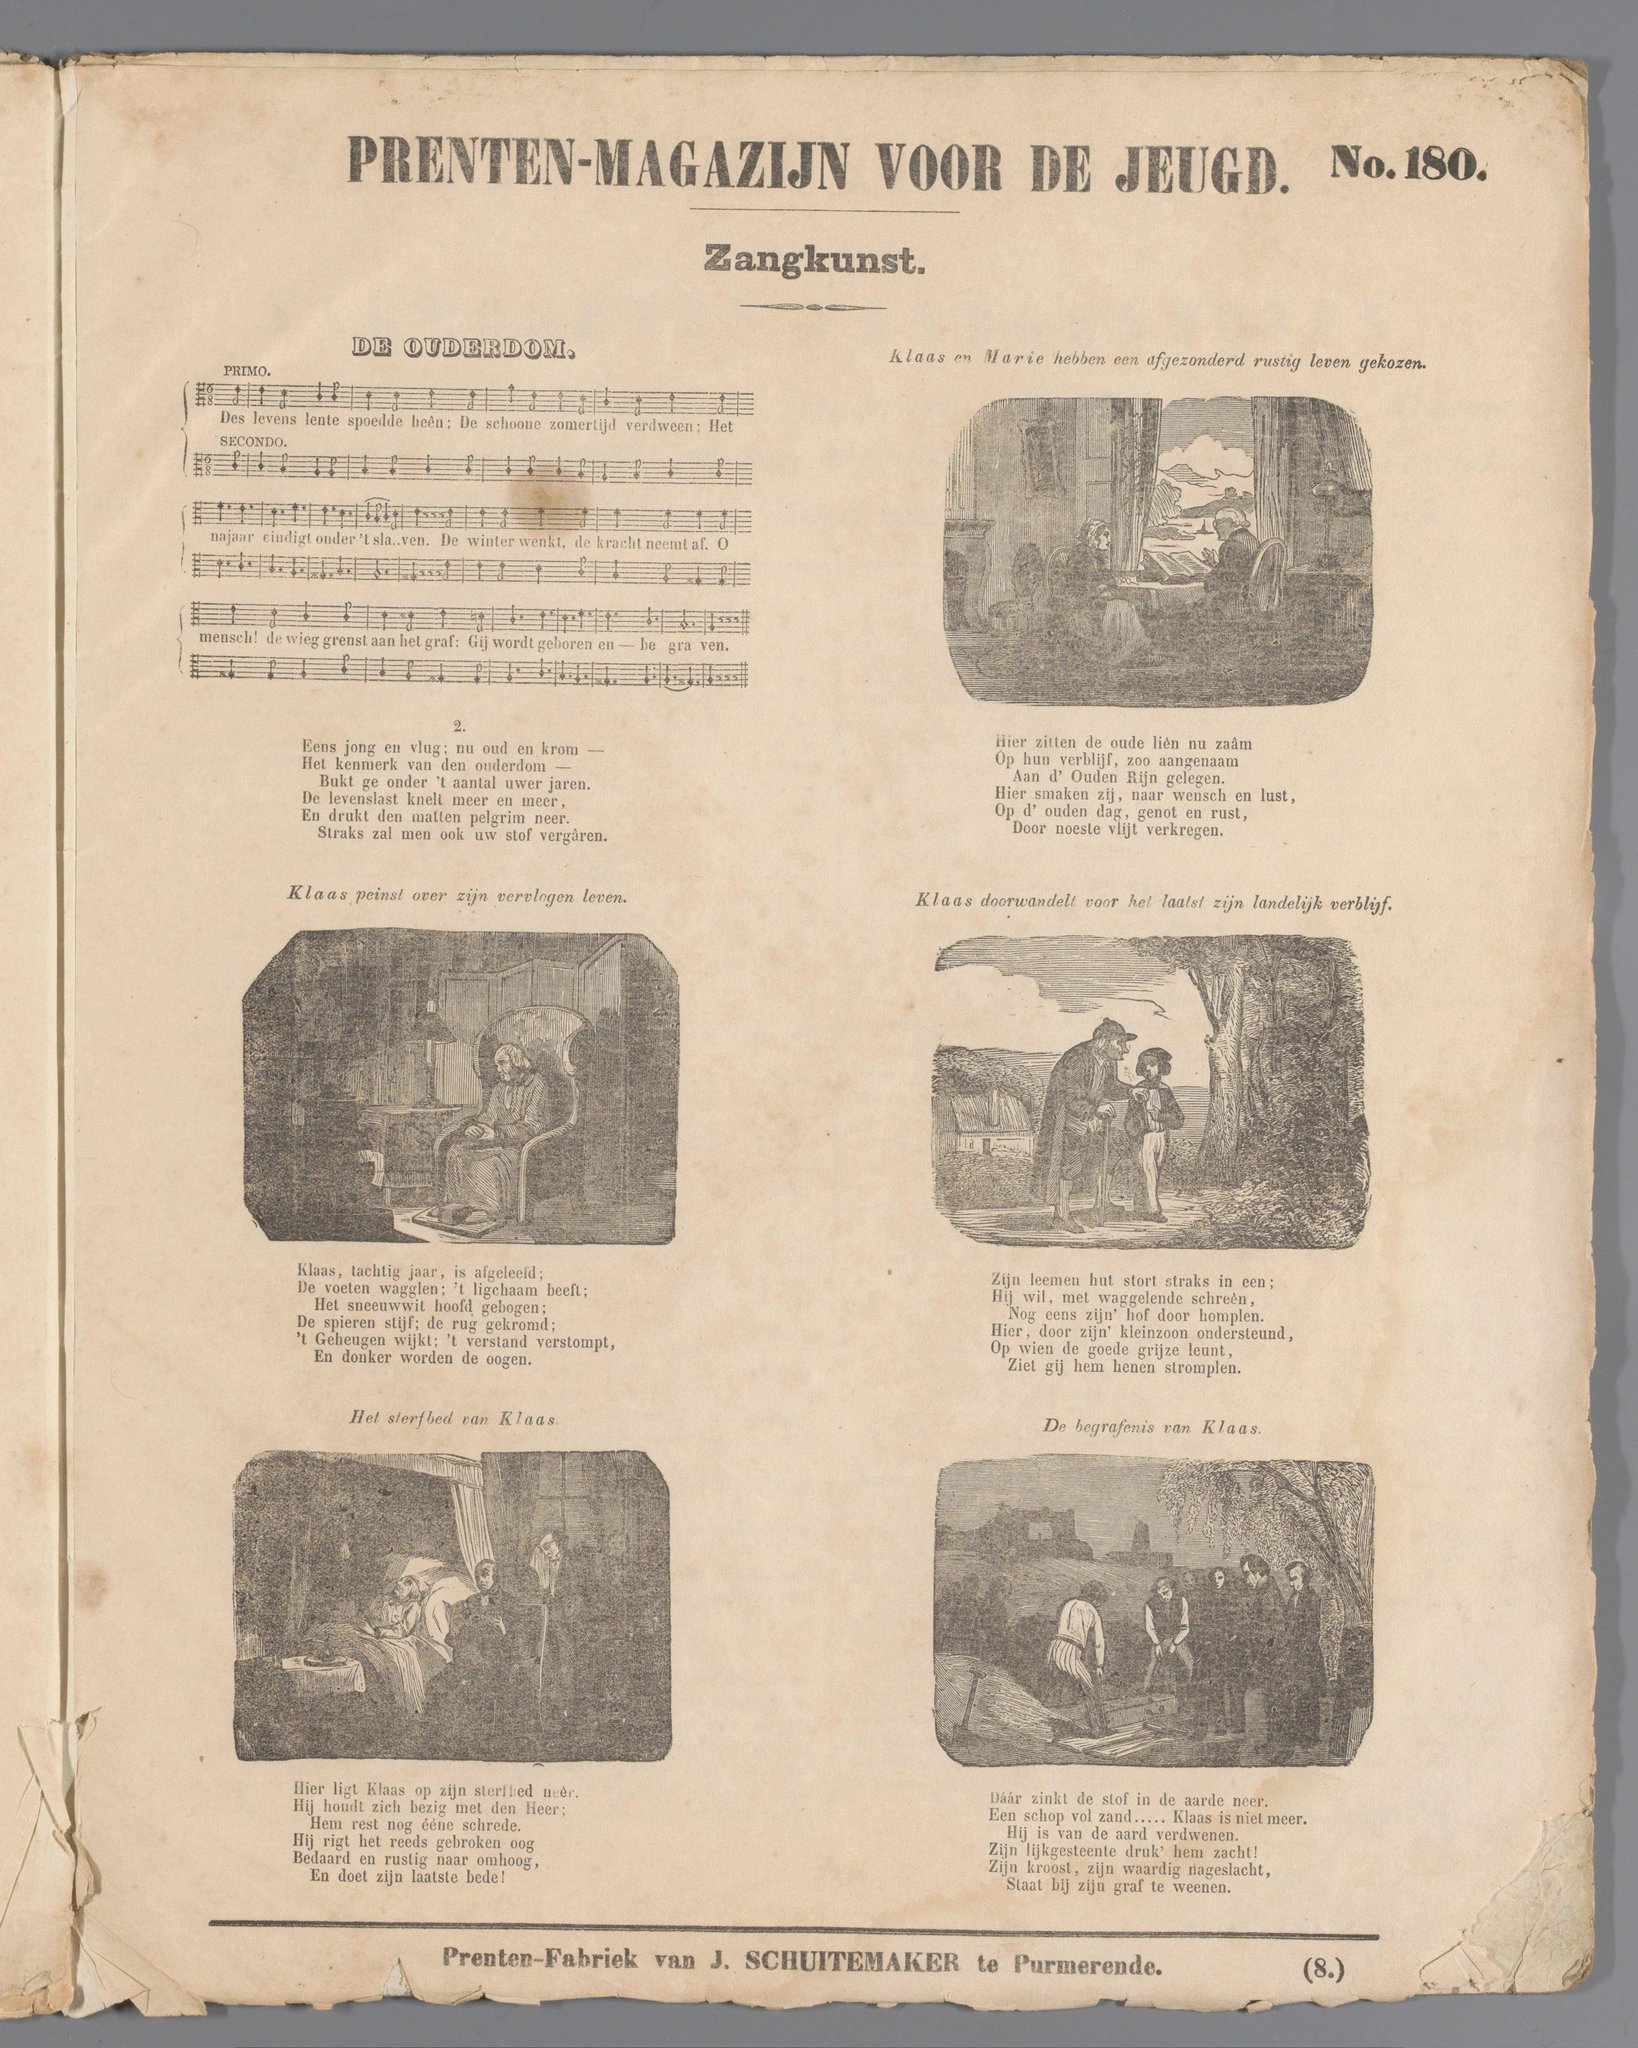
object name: print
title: Prenten-magazijn voor de jeugd / Zangkunst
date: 1853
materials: paper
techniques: letterpress printing, engraving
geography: netherlands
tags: deathbed, old man, printed edition of musical score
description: Blad met muziekstuk 'De ouderdom' en 5 voorstellingen: Klaas en Marie hebben een afgezonderd rustig leven gekozen, Klaas peinst over zijn vervlogen leven, Klaas doorwandelt voor het laatst zijn landelijk verblijf, het sterfbed van Klaas en de begrafenis van Klaas. Onder de voorstellingen diverse coupletten van het muziekstuk. Genummerd rechtsboven: No. 180, linksonder: (8.).